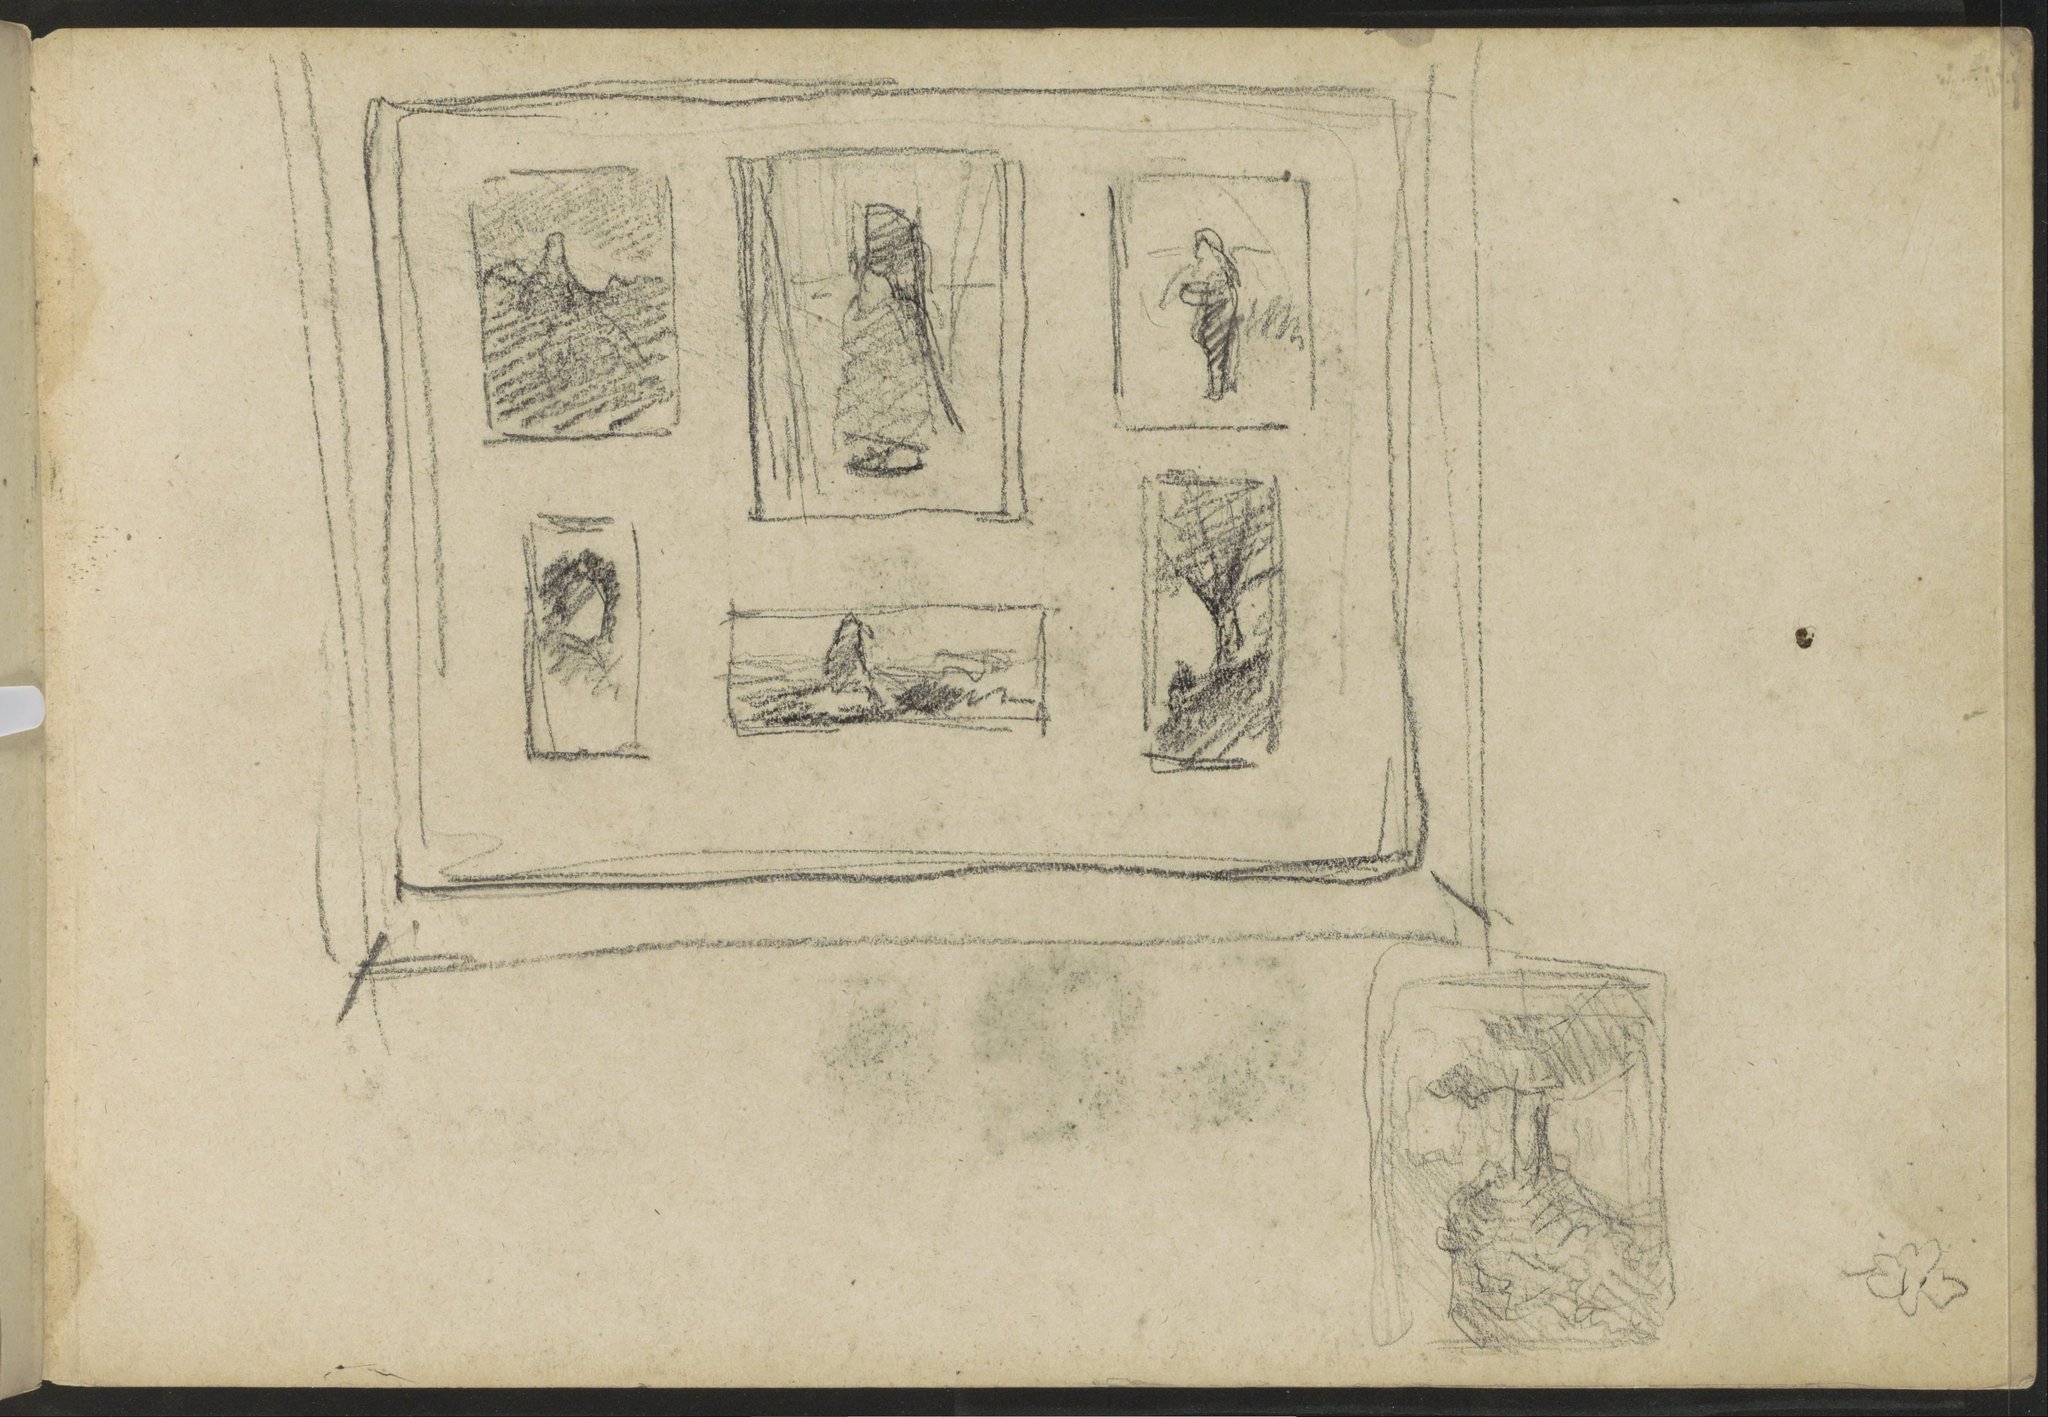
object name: endleaf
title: Wand met kunstwerken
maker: willem witsen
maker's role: draughtsman, painter, print maker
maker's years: 1860-1923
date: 1882-1884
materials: chalk, paper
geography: ewijkshoeve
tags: fence, wall, paling, cultivated land (+ landscape with figures, staffage), frame of painting, etc.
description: Op de werken figuren die op het land aan het werk zijn. Schutblad B, achterste schutblad, uit een schetsboek met 19 bladen.